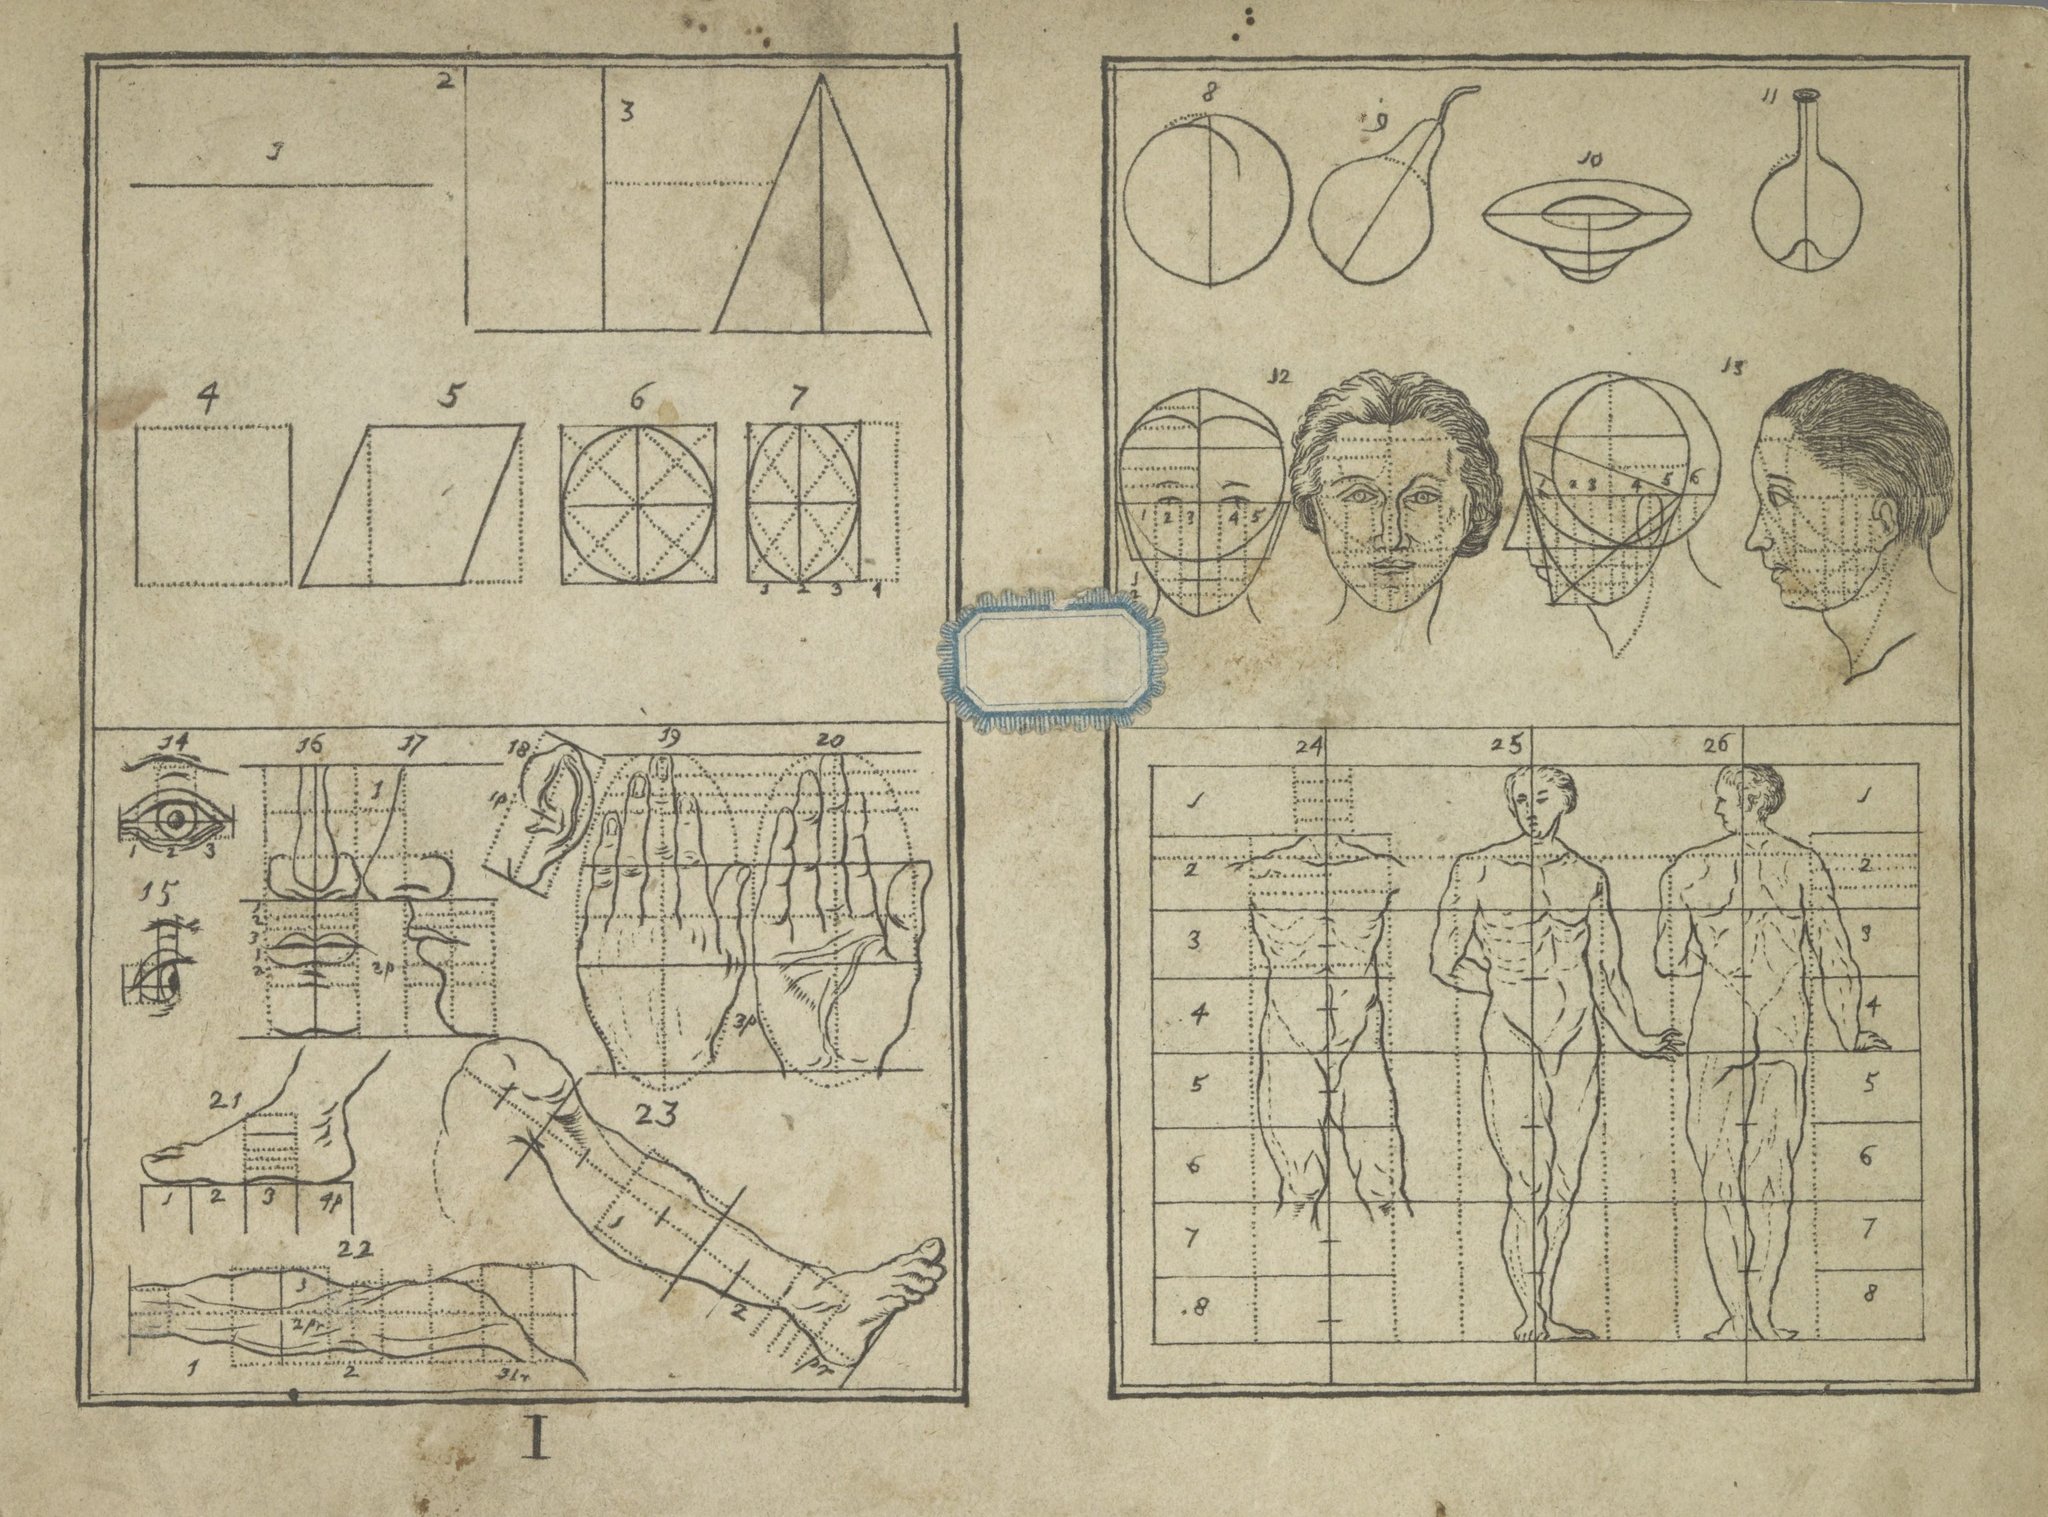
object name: album leaf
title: Spiegel der natuur en school der teekenkunde (...)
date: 1787-1833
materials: paper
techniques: etching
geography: amsterdam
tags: parts of the human body (skeleton excepted), canon, proportions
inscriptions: label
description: Twee voorstellingen op een albumblad met tekenvoorbeelden van verschillende lichaamsdelen en de verhoudingen van het menselijk lichaam. Onder andere handen, een been en gezichten. Rechtsonder genummerd: I. De prent maakt deel uit van een album.